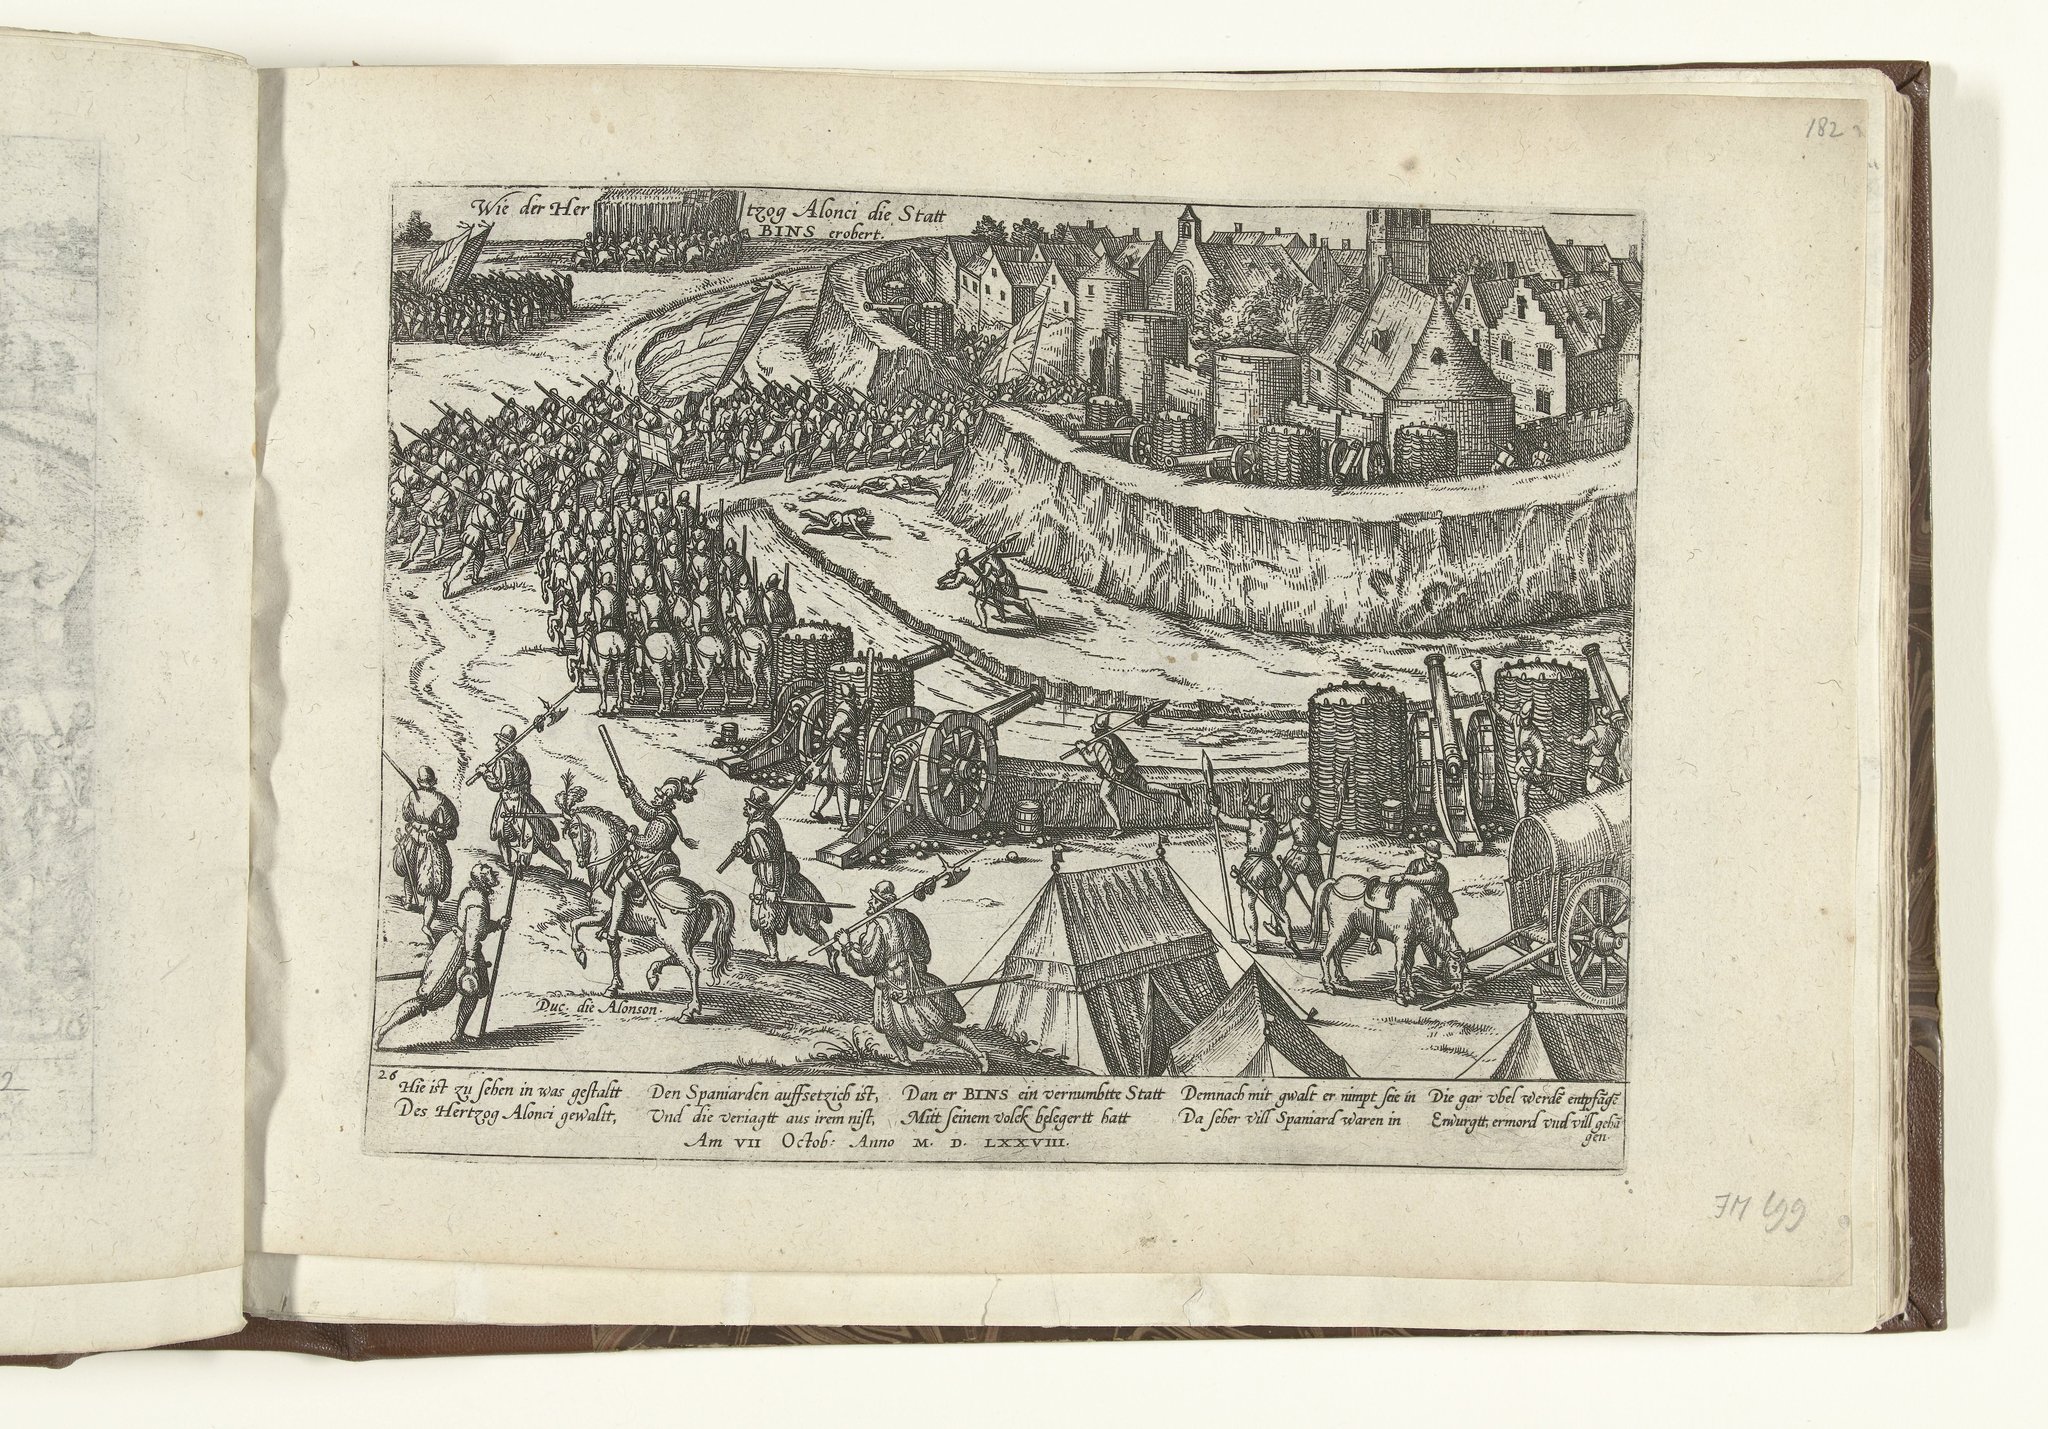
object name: album leaf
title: Hertog van Anjou neemt Binche in, 1578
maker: frans hogenberg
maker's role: print maker, publisher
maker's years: 1538-1590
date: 1578-1580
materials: paper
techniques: etching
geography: cologne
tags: paris, françois-hercule de valois (hertog van anjou), capture of city (after the siege), binche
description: Na beleg geeft de stad Binche in Henegouwen zich over aan de hertog van Anjou, 7 oktober 1578. Op de voorgrond de hertog van Anjou te paard, boven trekken zijn legers de stad in. Met onderschrift van 10 regels in het Duits. Genummerd: 26.